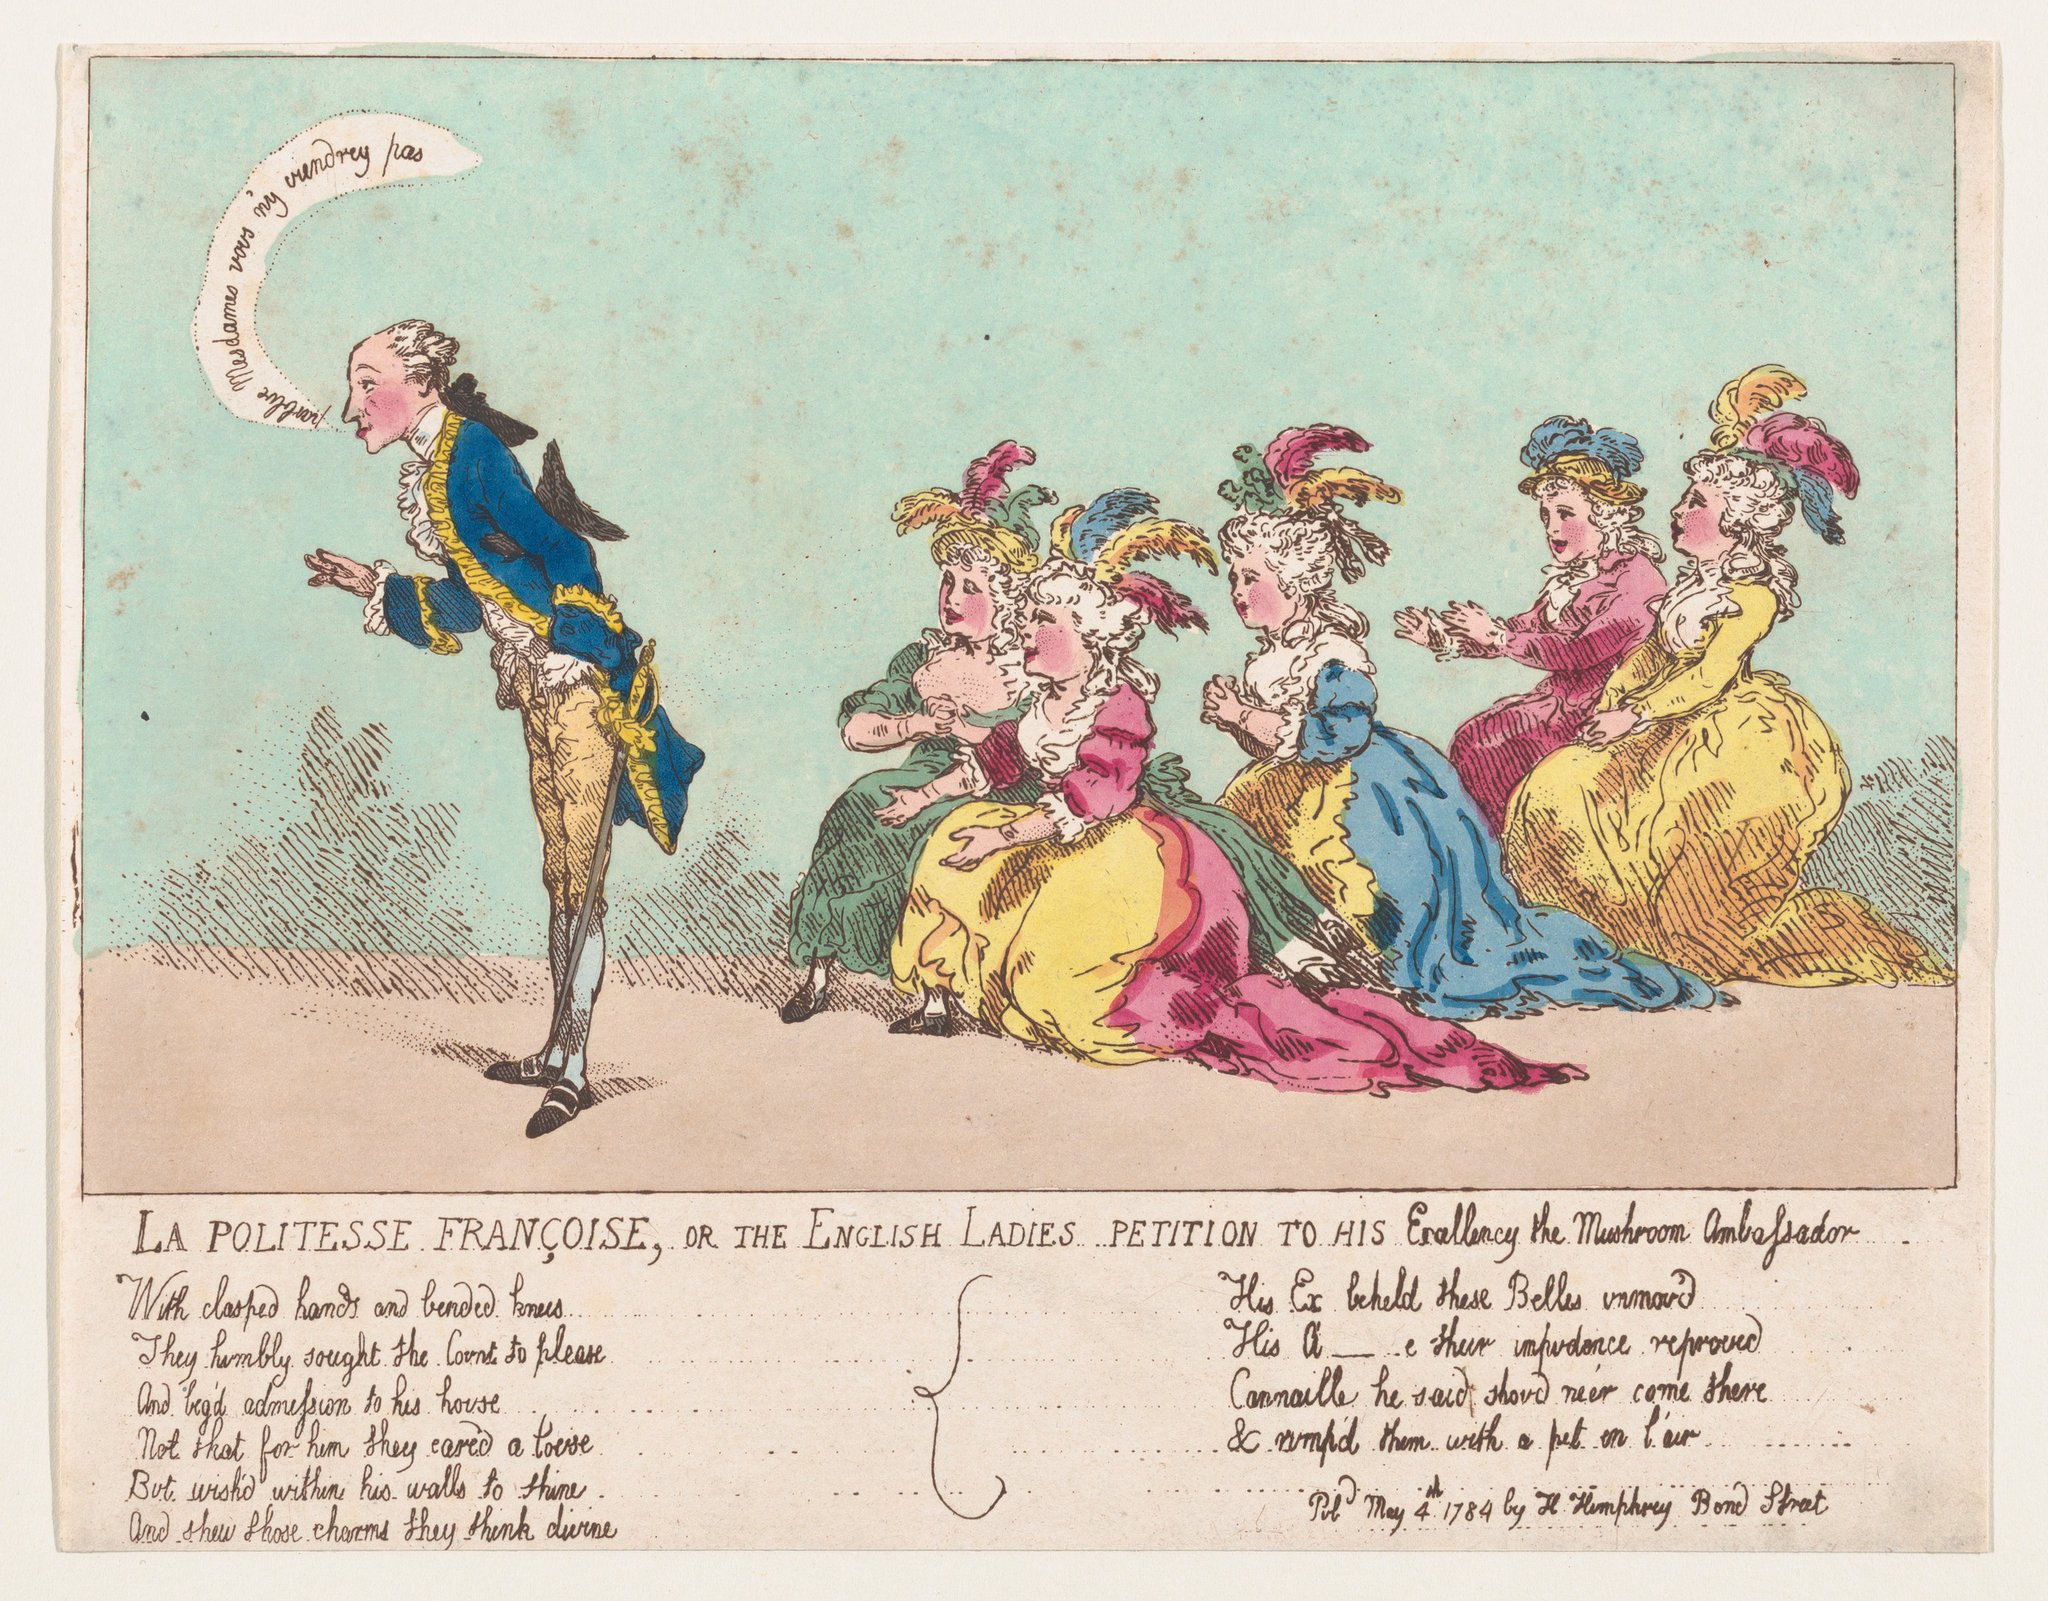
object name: print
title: La politesse Françoise, or the English ladies petition to His Excellency the Mushroom Ambassador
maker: thomas rowlandson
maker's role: artist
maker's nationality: british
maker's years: 1757-1827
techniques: etching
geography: london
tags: satire,men,women